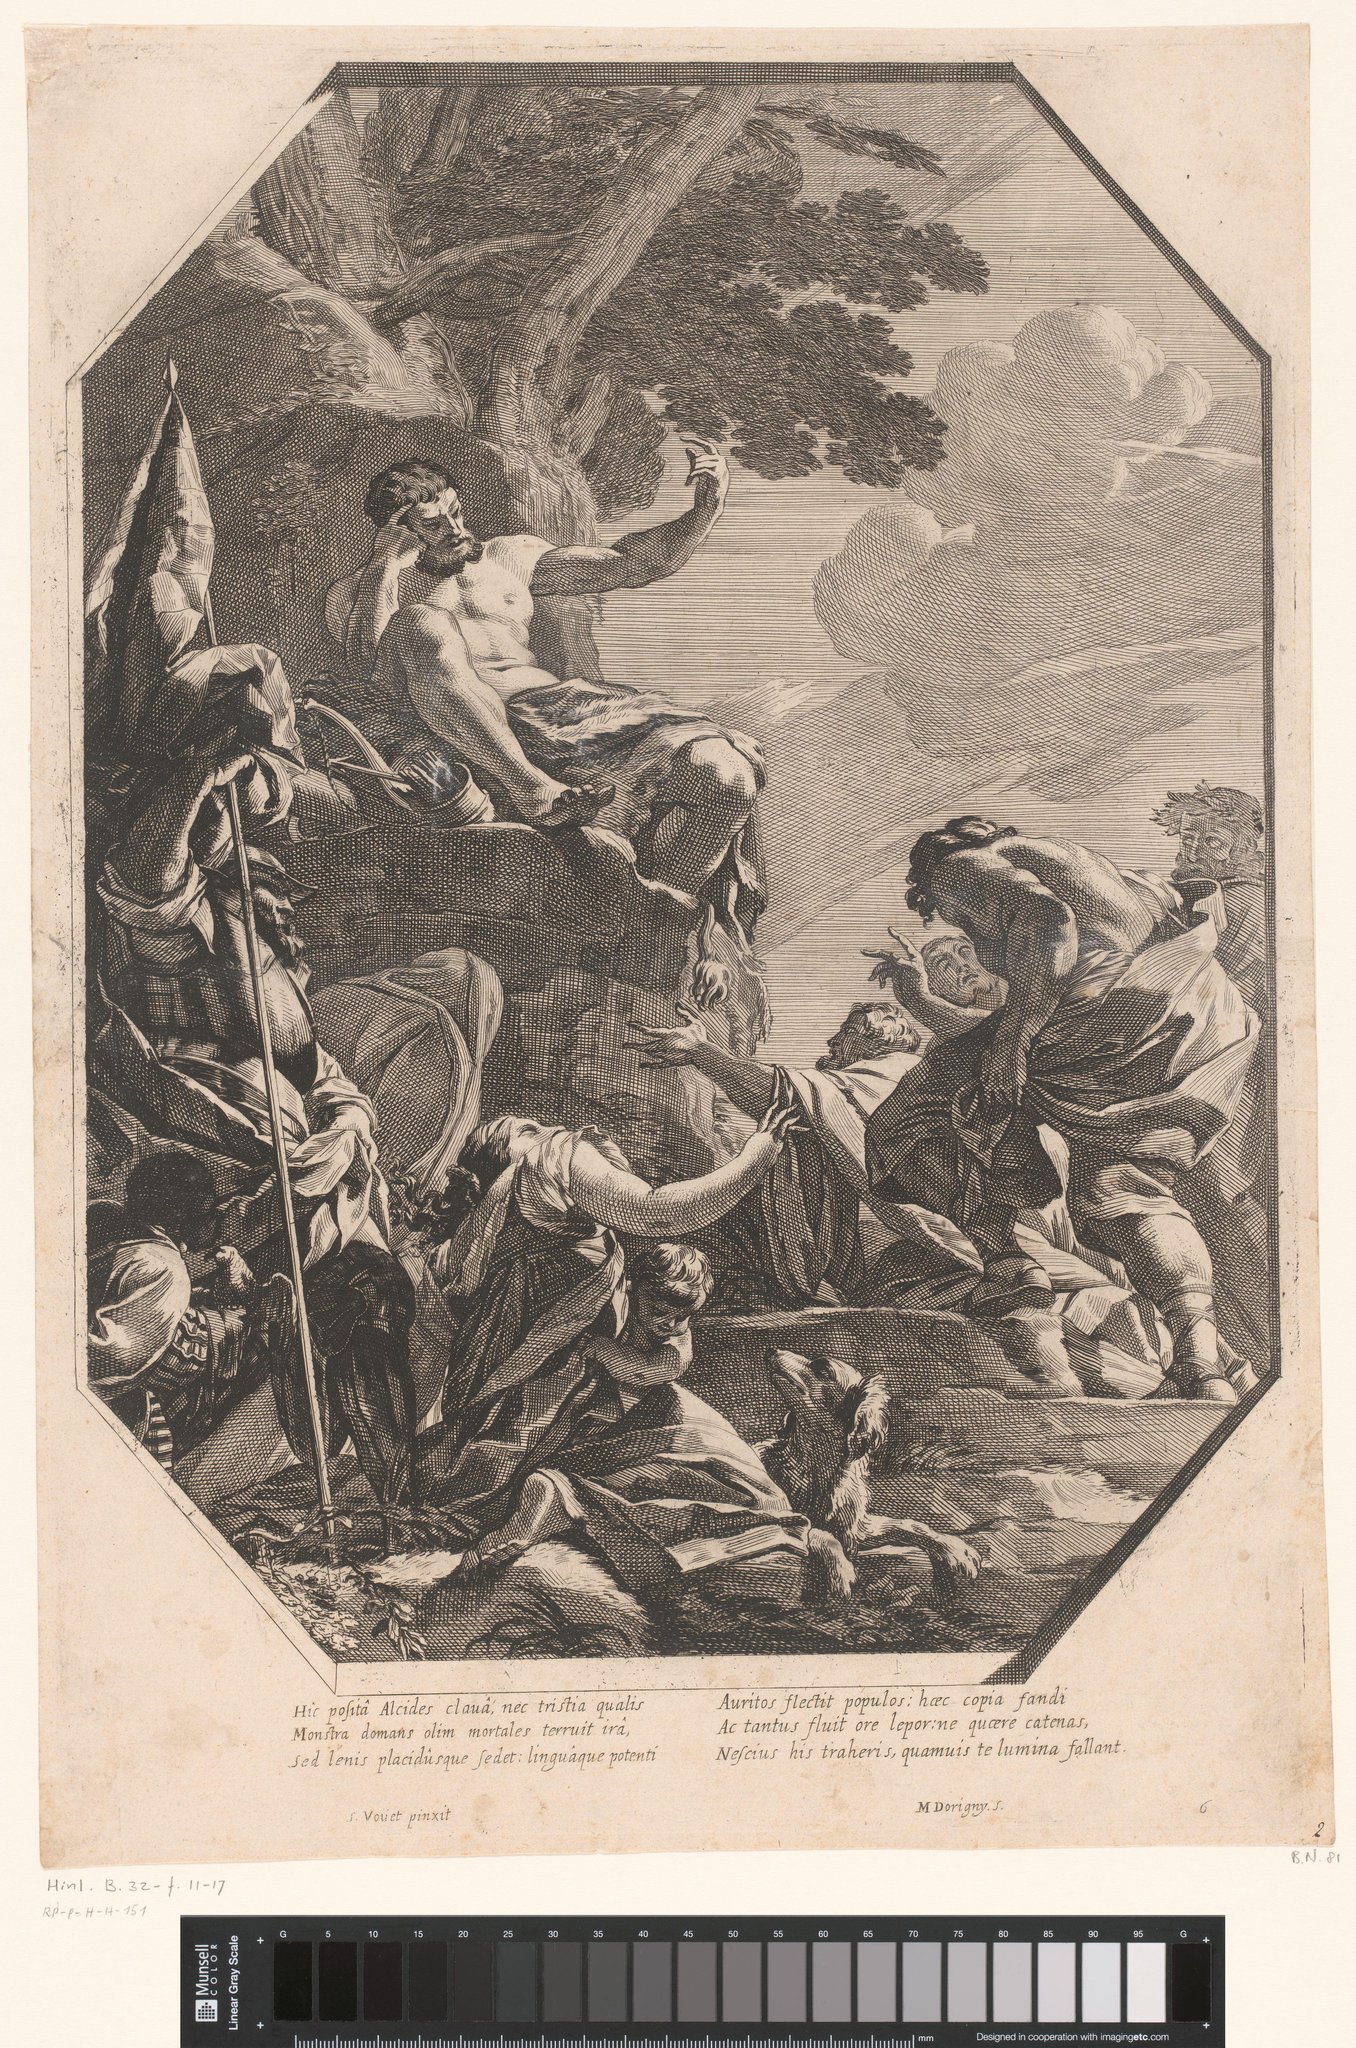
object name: print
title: Serie naar schilderijen door Vouet voor de bibliotheek van het Hôtel Séguier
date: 1640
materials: paper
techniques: engraving, etching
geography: france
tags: non-aggressive, friendly or neutral activities and relationships of hercules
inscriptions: collector's mark: ‘Hinloopen’, collector's mark: Lugt 11